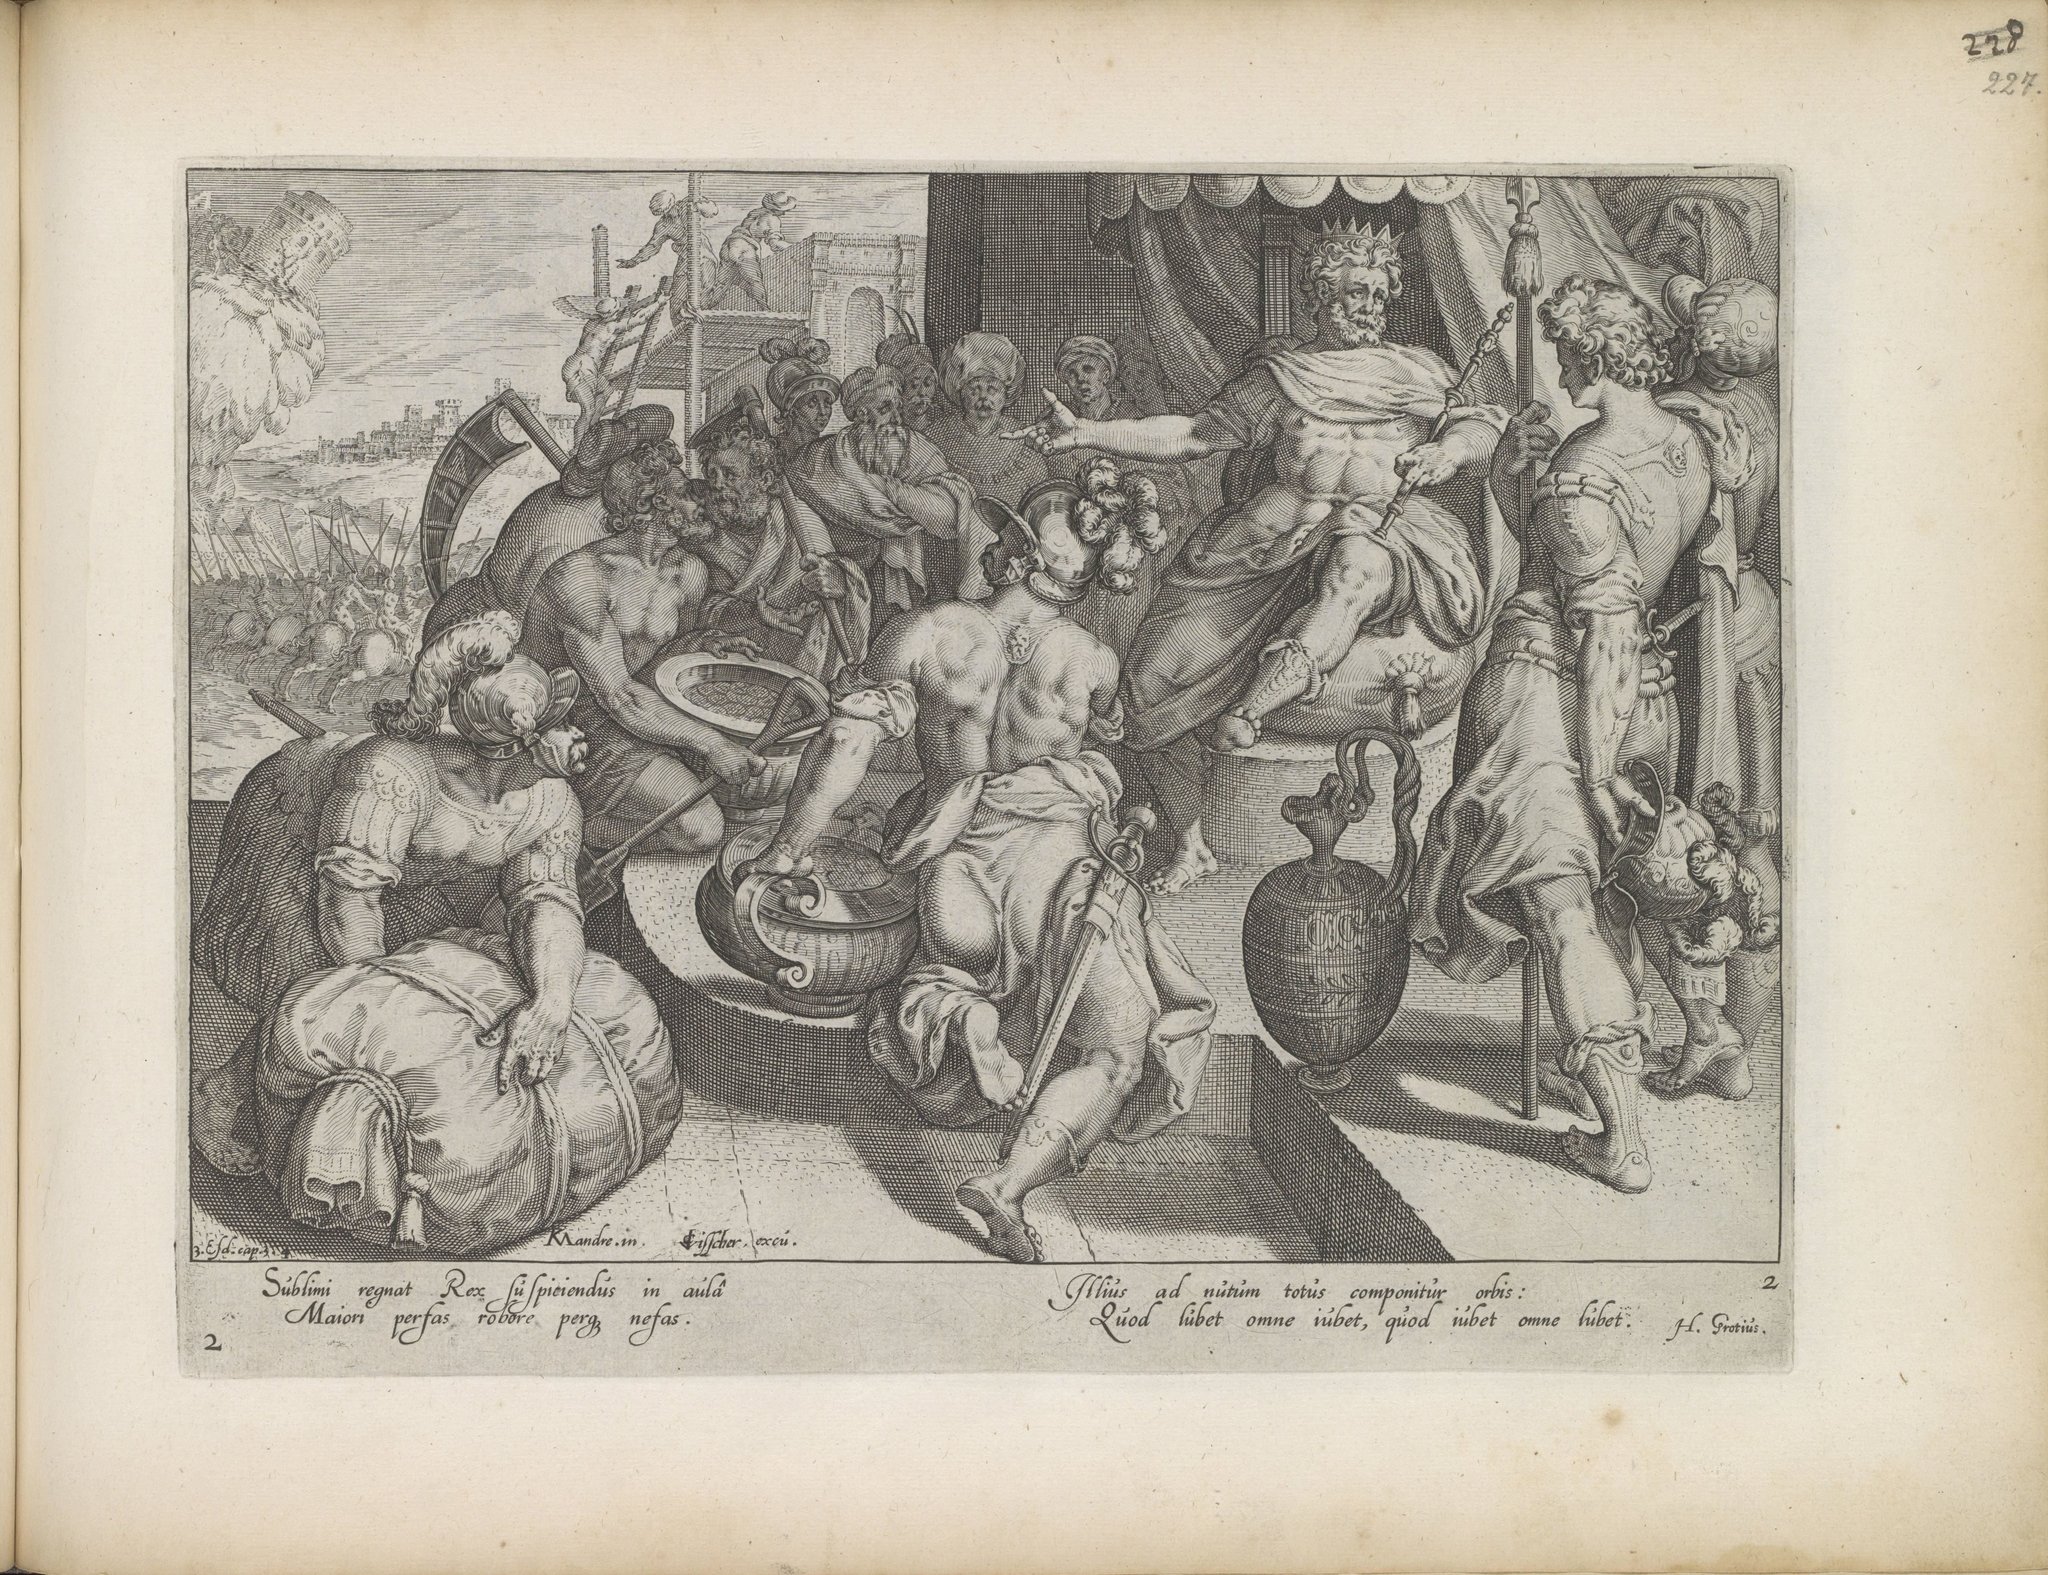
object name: album leaf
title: Macht van de koning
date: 1595-1596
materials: paper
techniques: engraving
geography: amsterdam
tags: the books of ezra, nehemiah, and esdras, the second guardsman says (writes) that the king is the strongest ~ contest of the three guardsmen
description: Verschillende personen brengen hun schatten naar de koning die op zijn troon zit. Twee mannen dragen grote vazen met munten, een andere man brengt een baal dure stoffen. Op de achtergrond wordt een nieuw paleis gebouwd en trekt een leger ten strijde. Linksonder een verwijzing naar de tekst in 3 Esdras 3-4. Onder de voorstelling verzen in het Latijn. Deze prent maakt deel uit van een album.